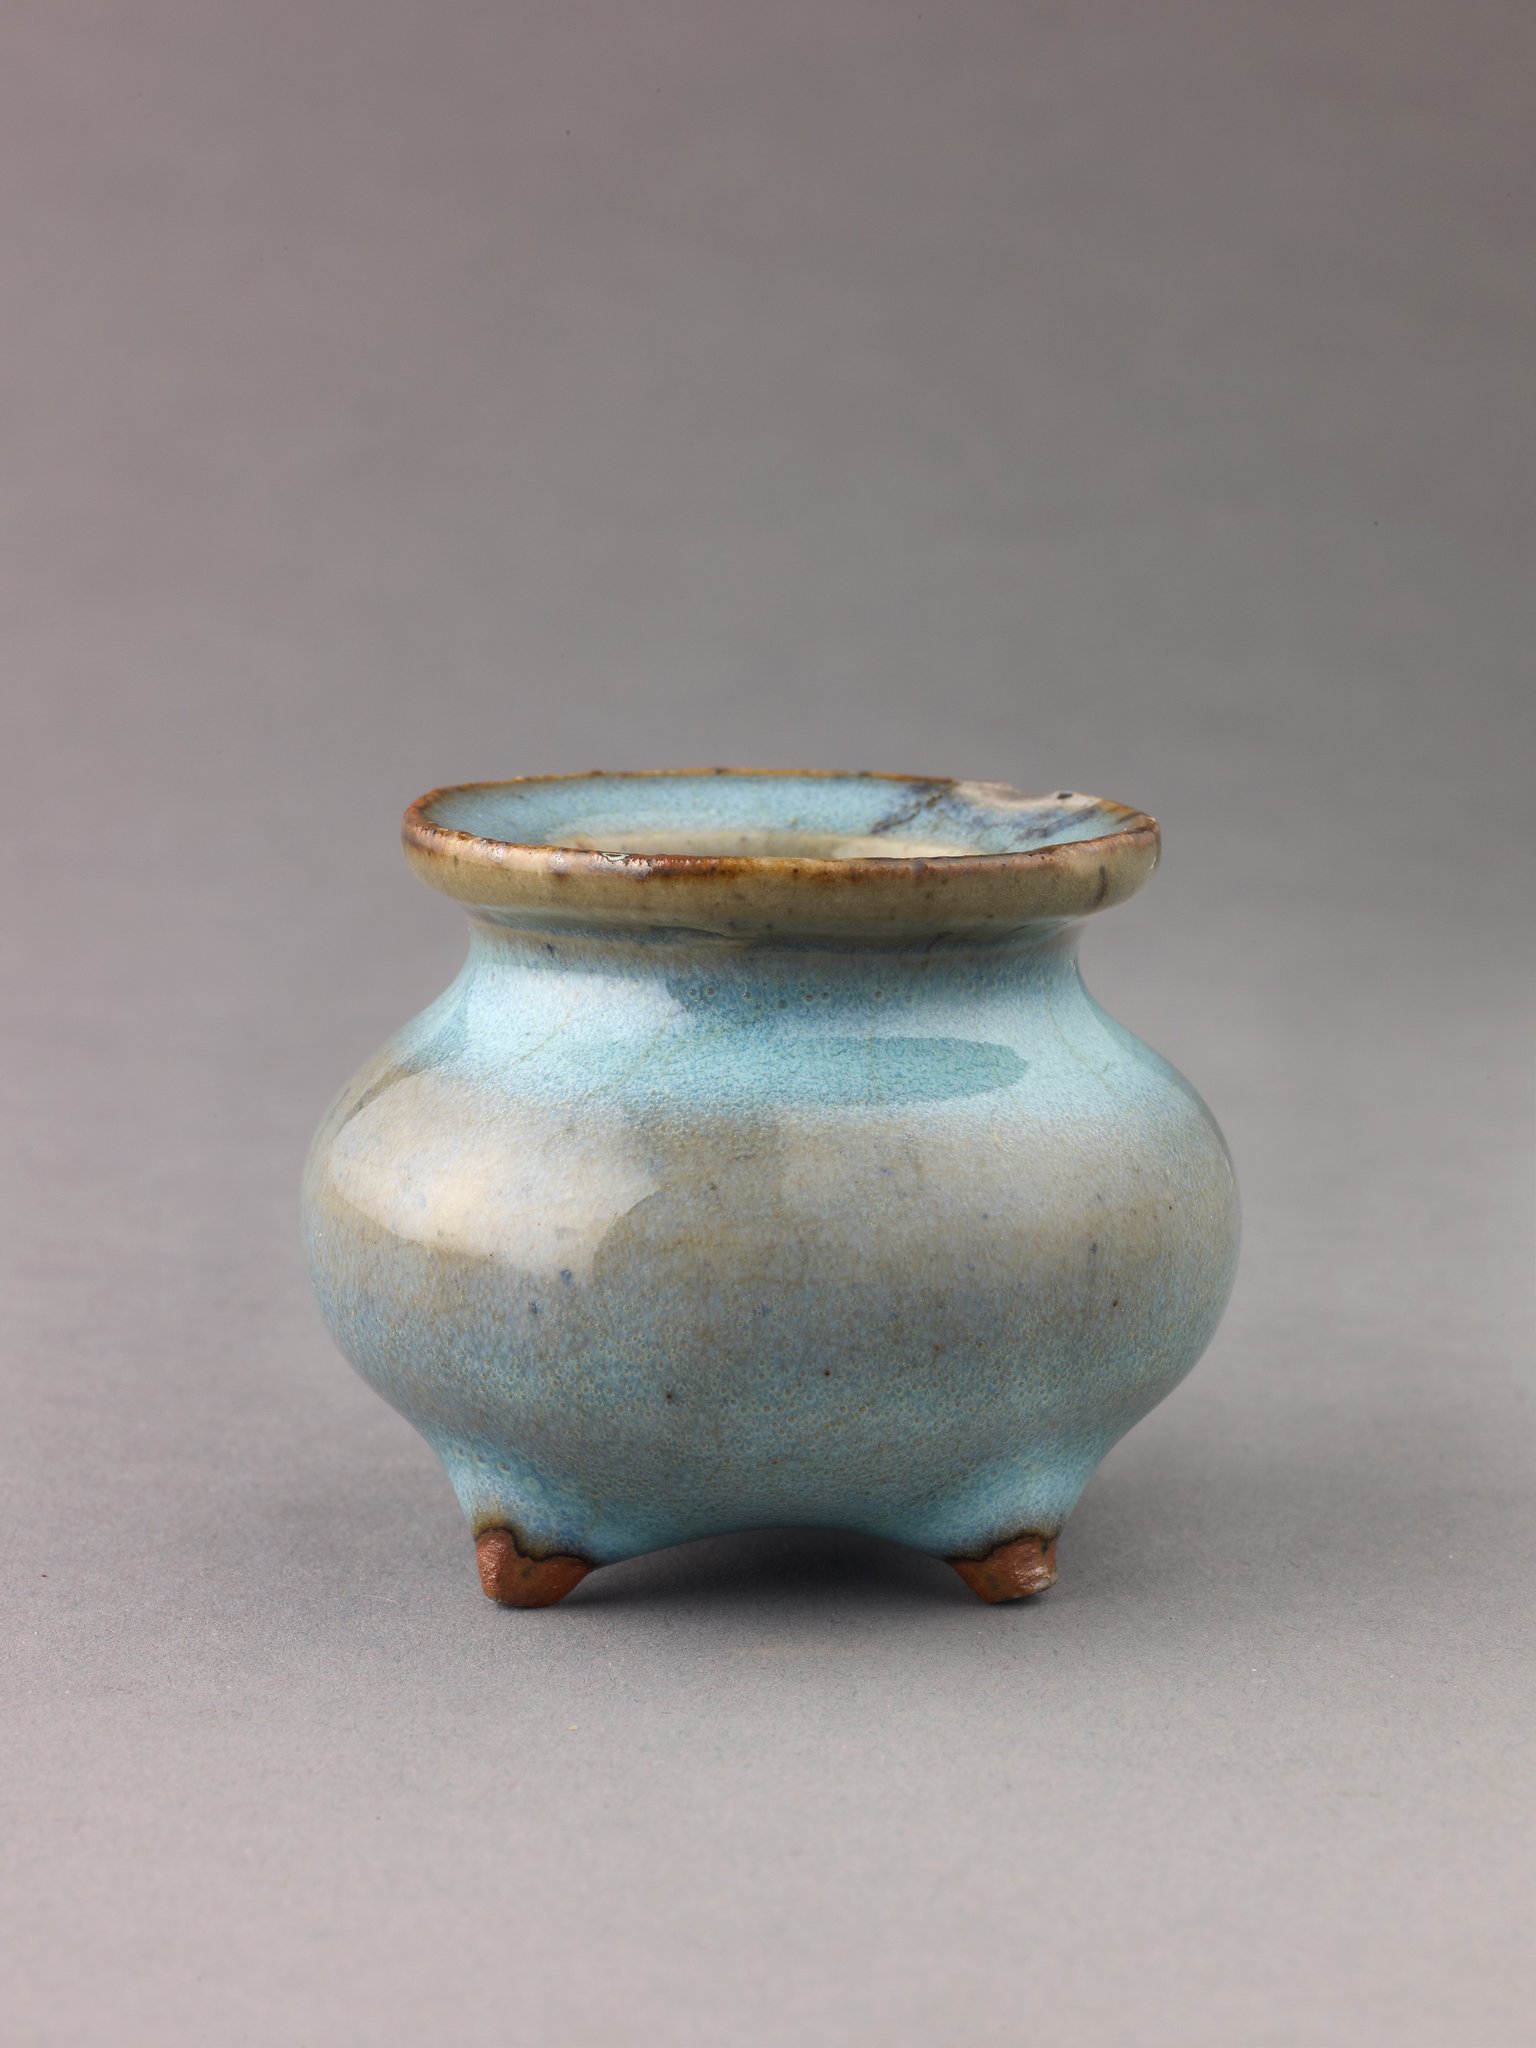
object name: incense burner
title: Miniature incense burner, Jun ware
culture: chinese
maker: chinese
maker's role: artist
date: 1201-1400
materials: glaze, stoneware